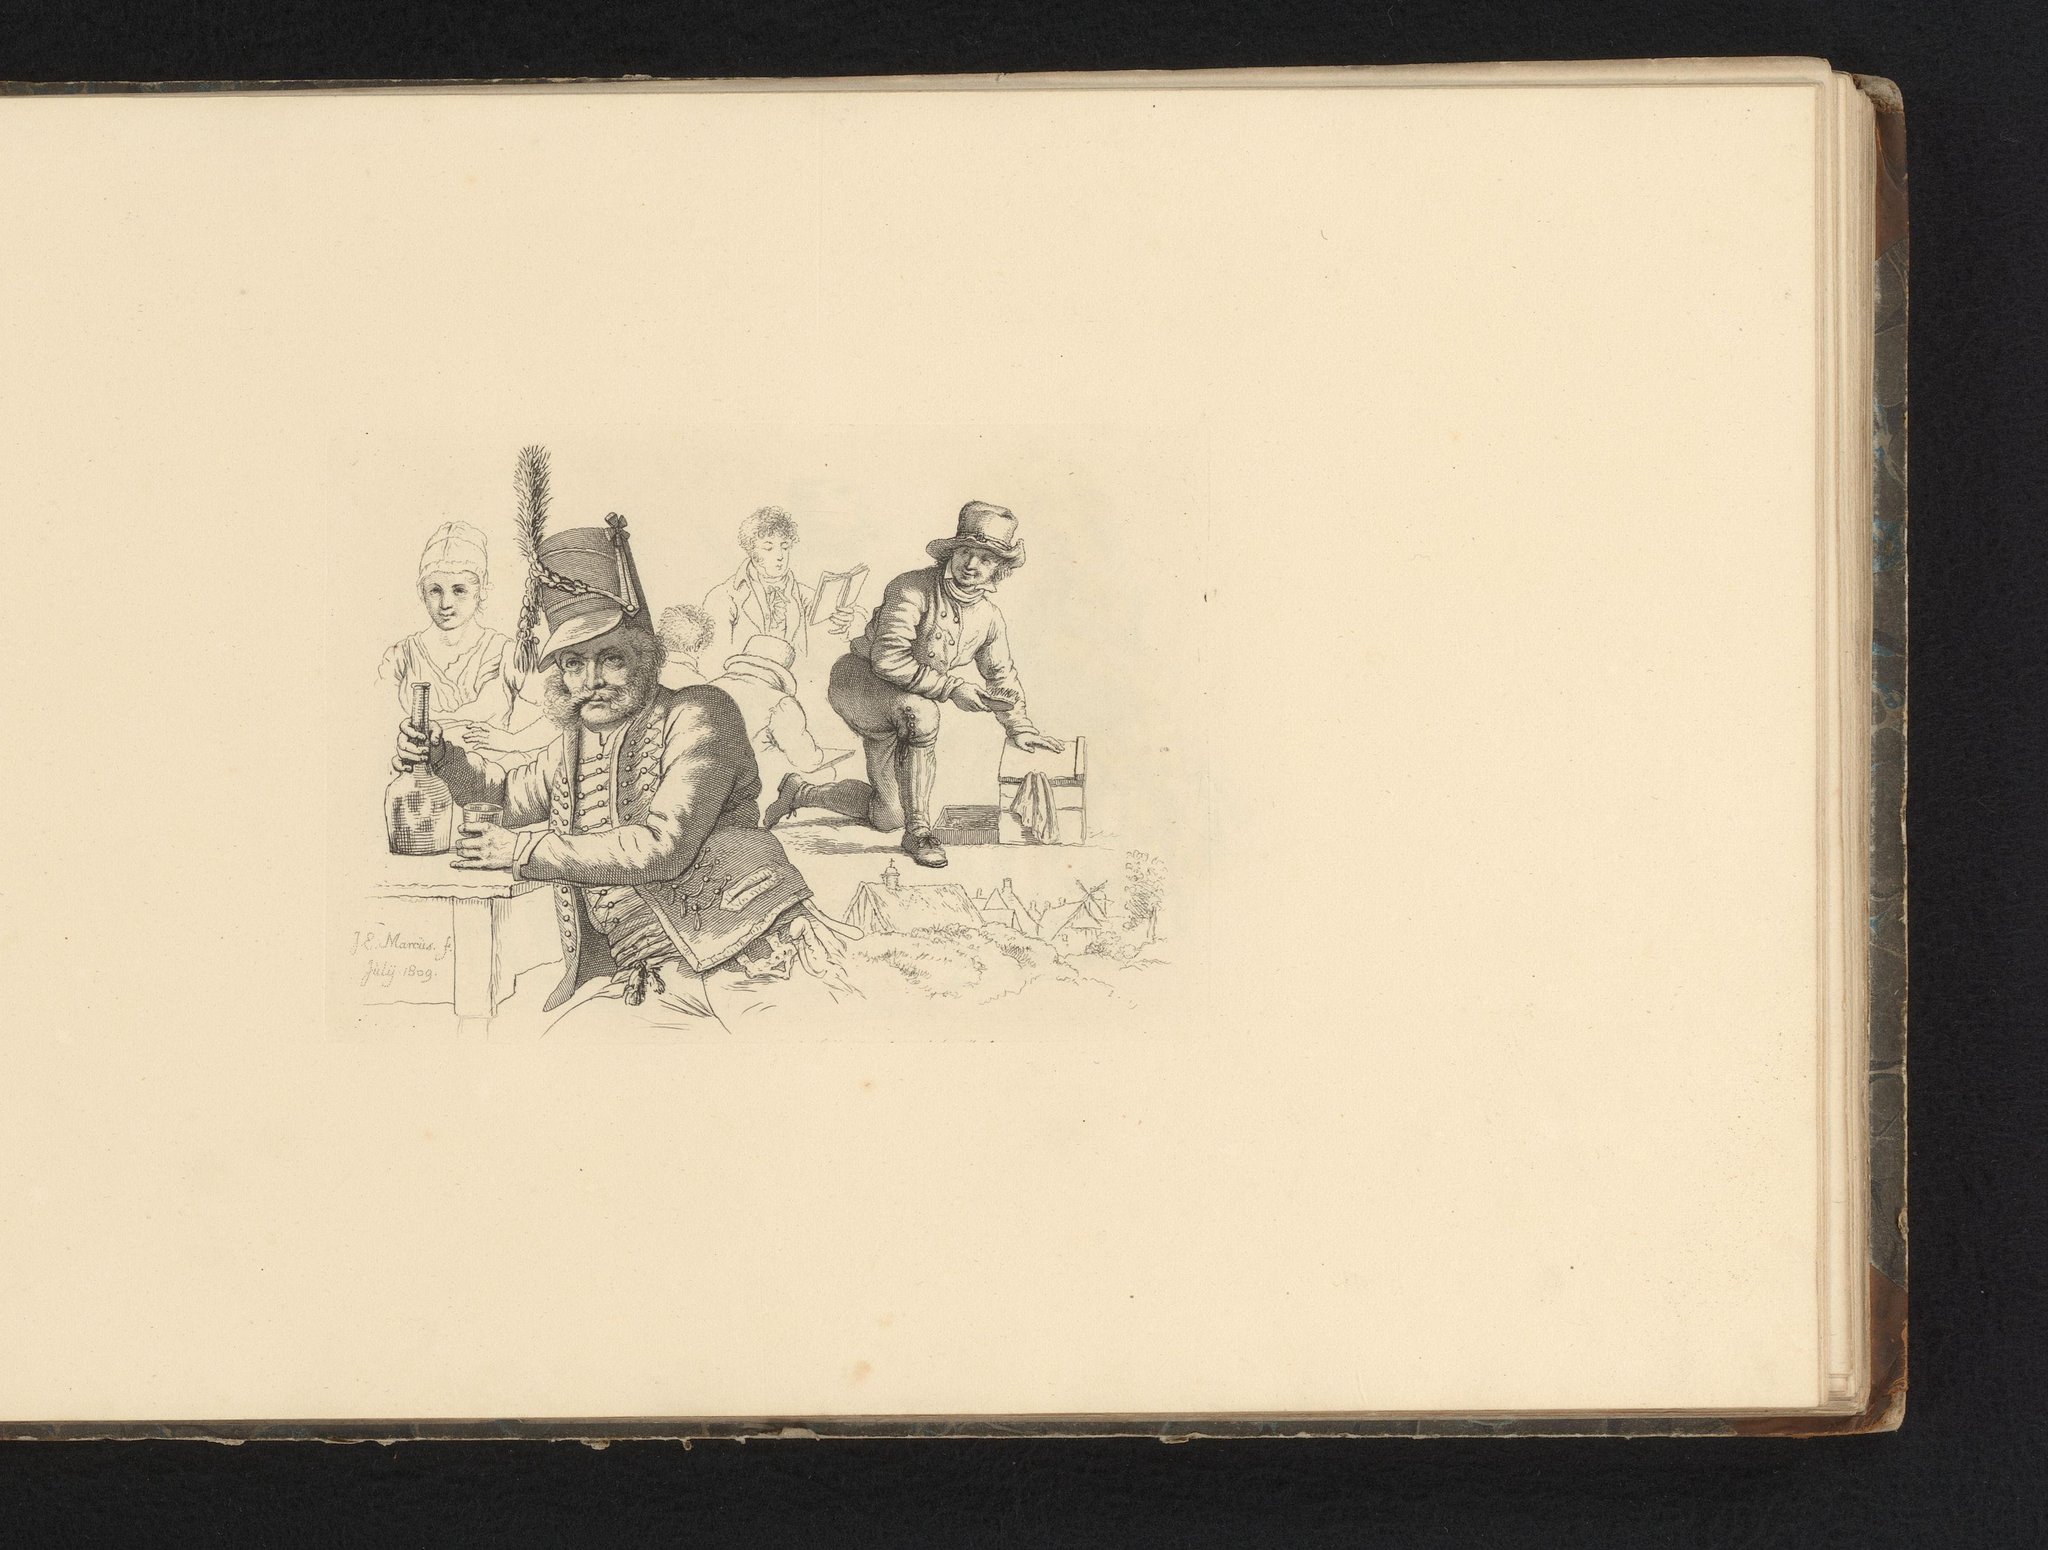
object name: album leaf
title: Studiebeelden en fragmenten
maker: jacob ernst marcus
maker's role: draughtsman, print maker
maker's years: 1774-1826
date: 1807-1809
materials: paper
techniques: etching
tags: prospect of village, silhouette of village, canteen ~ the soldier off duty, reading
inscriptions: date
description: Deze prent maakt deel uit van een album.